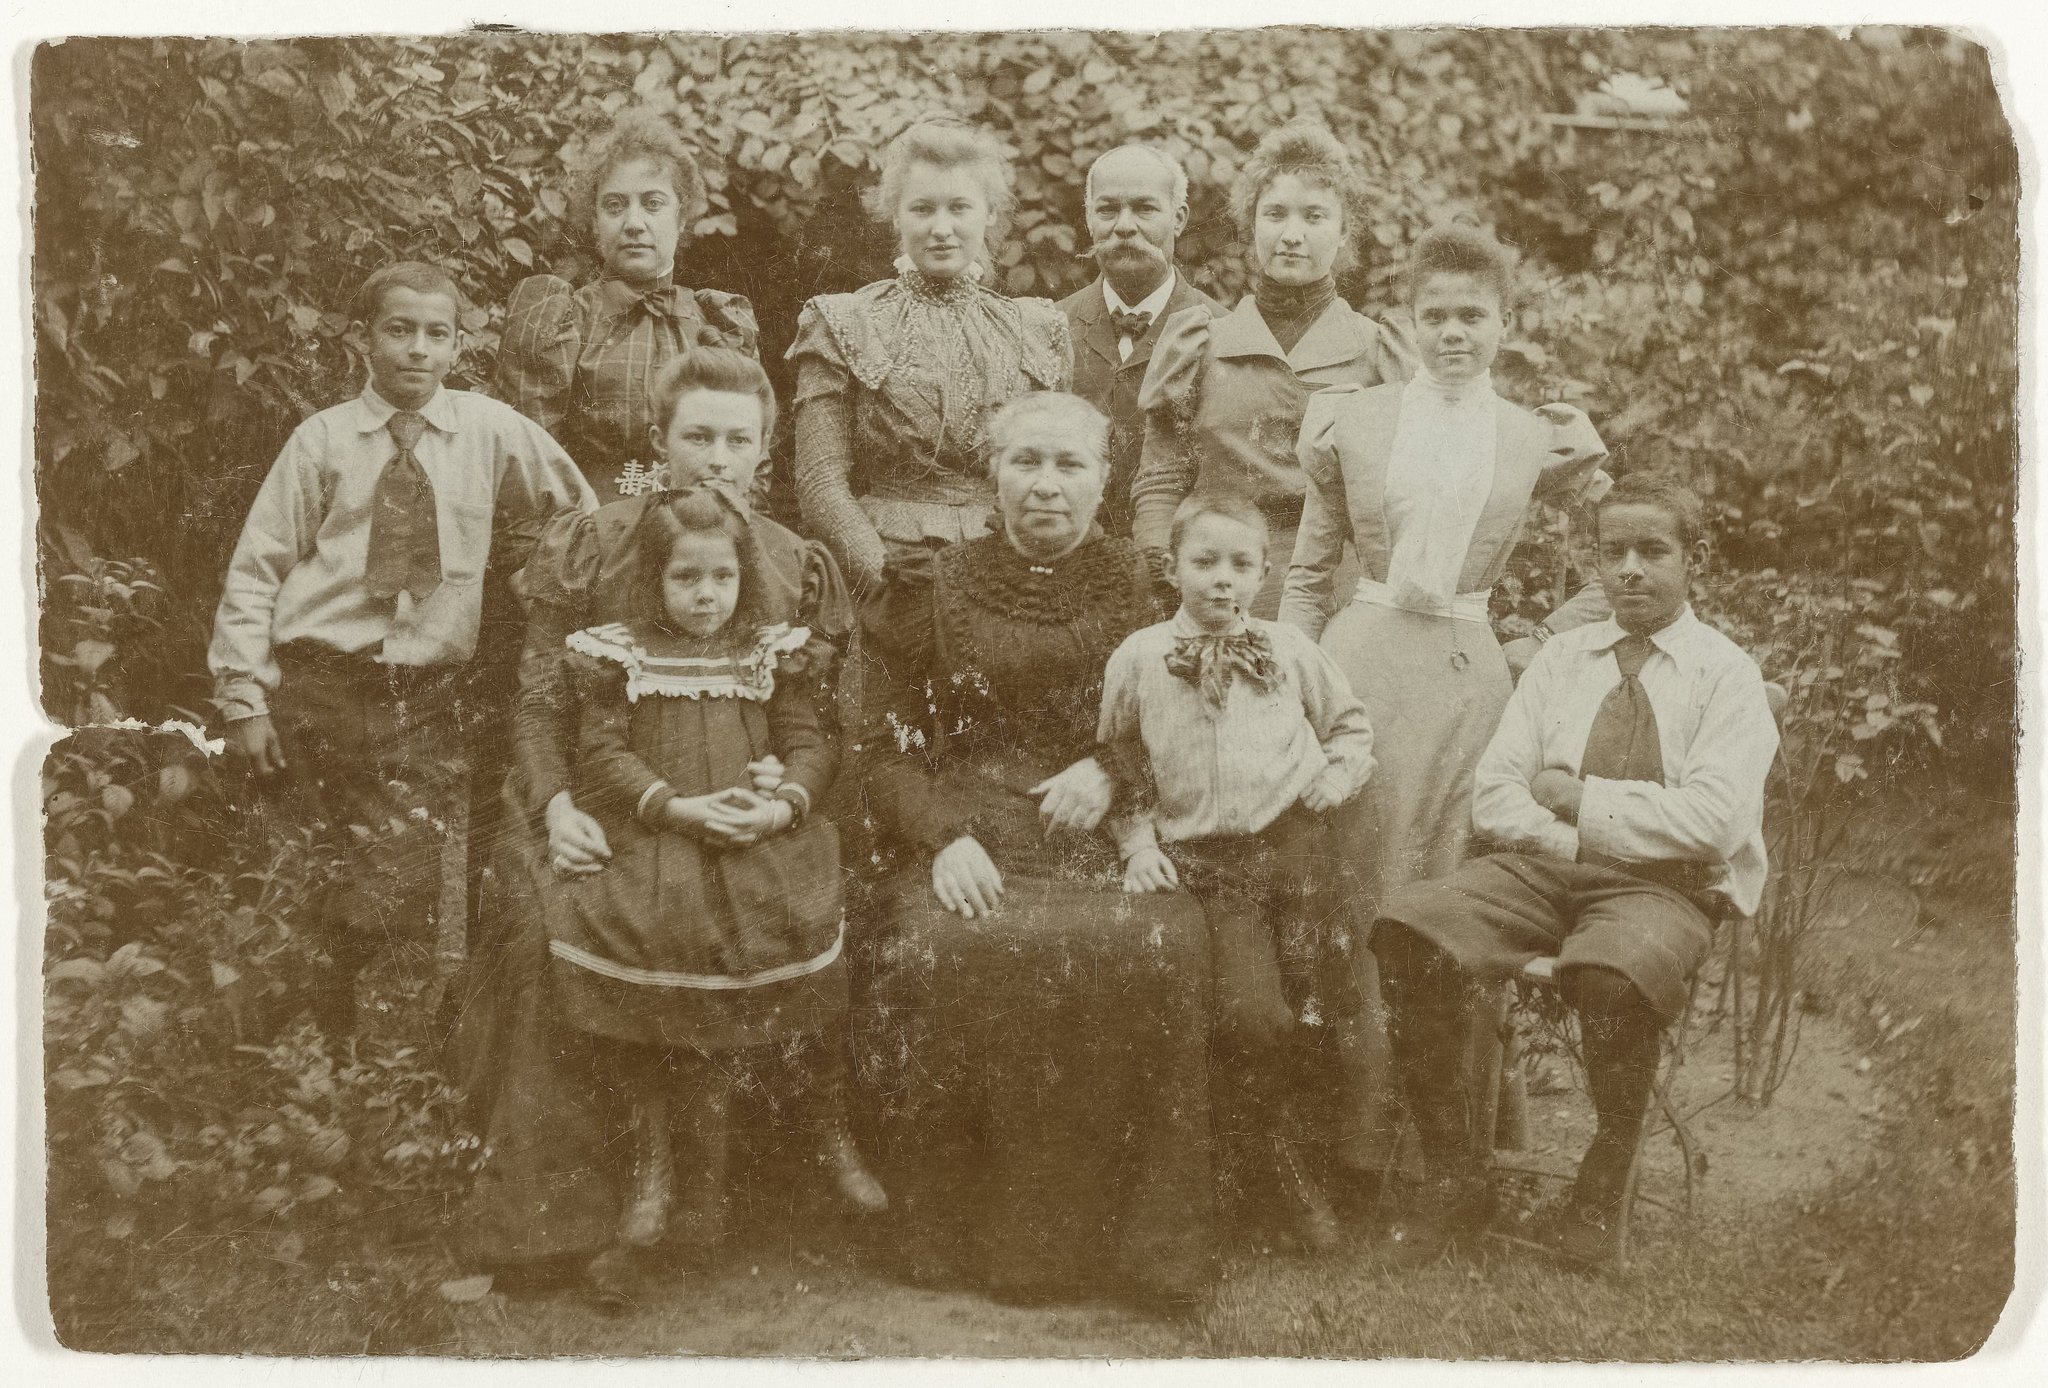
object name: photograph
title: Groepsportret van de Familie Wesenhagen-Loth in Den Haag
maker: Anonymous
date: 1898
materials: photographic support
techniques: photography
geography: the hague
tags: jacob evert wesenhagen, suriname, the hague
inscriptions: annotation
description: Groepsportret van de Familie Wesenhagen-Loth in Den Haag. Op het portret staan elf personen afgebeeld, van wie ten minste drie van Surinaamse komaf. Onderdeel van een groep objecten afkomstig van de familie Wesenhagen in Suriname.